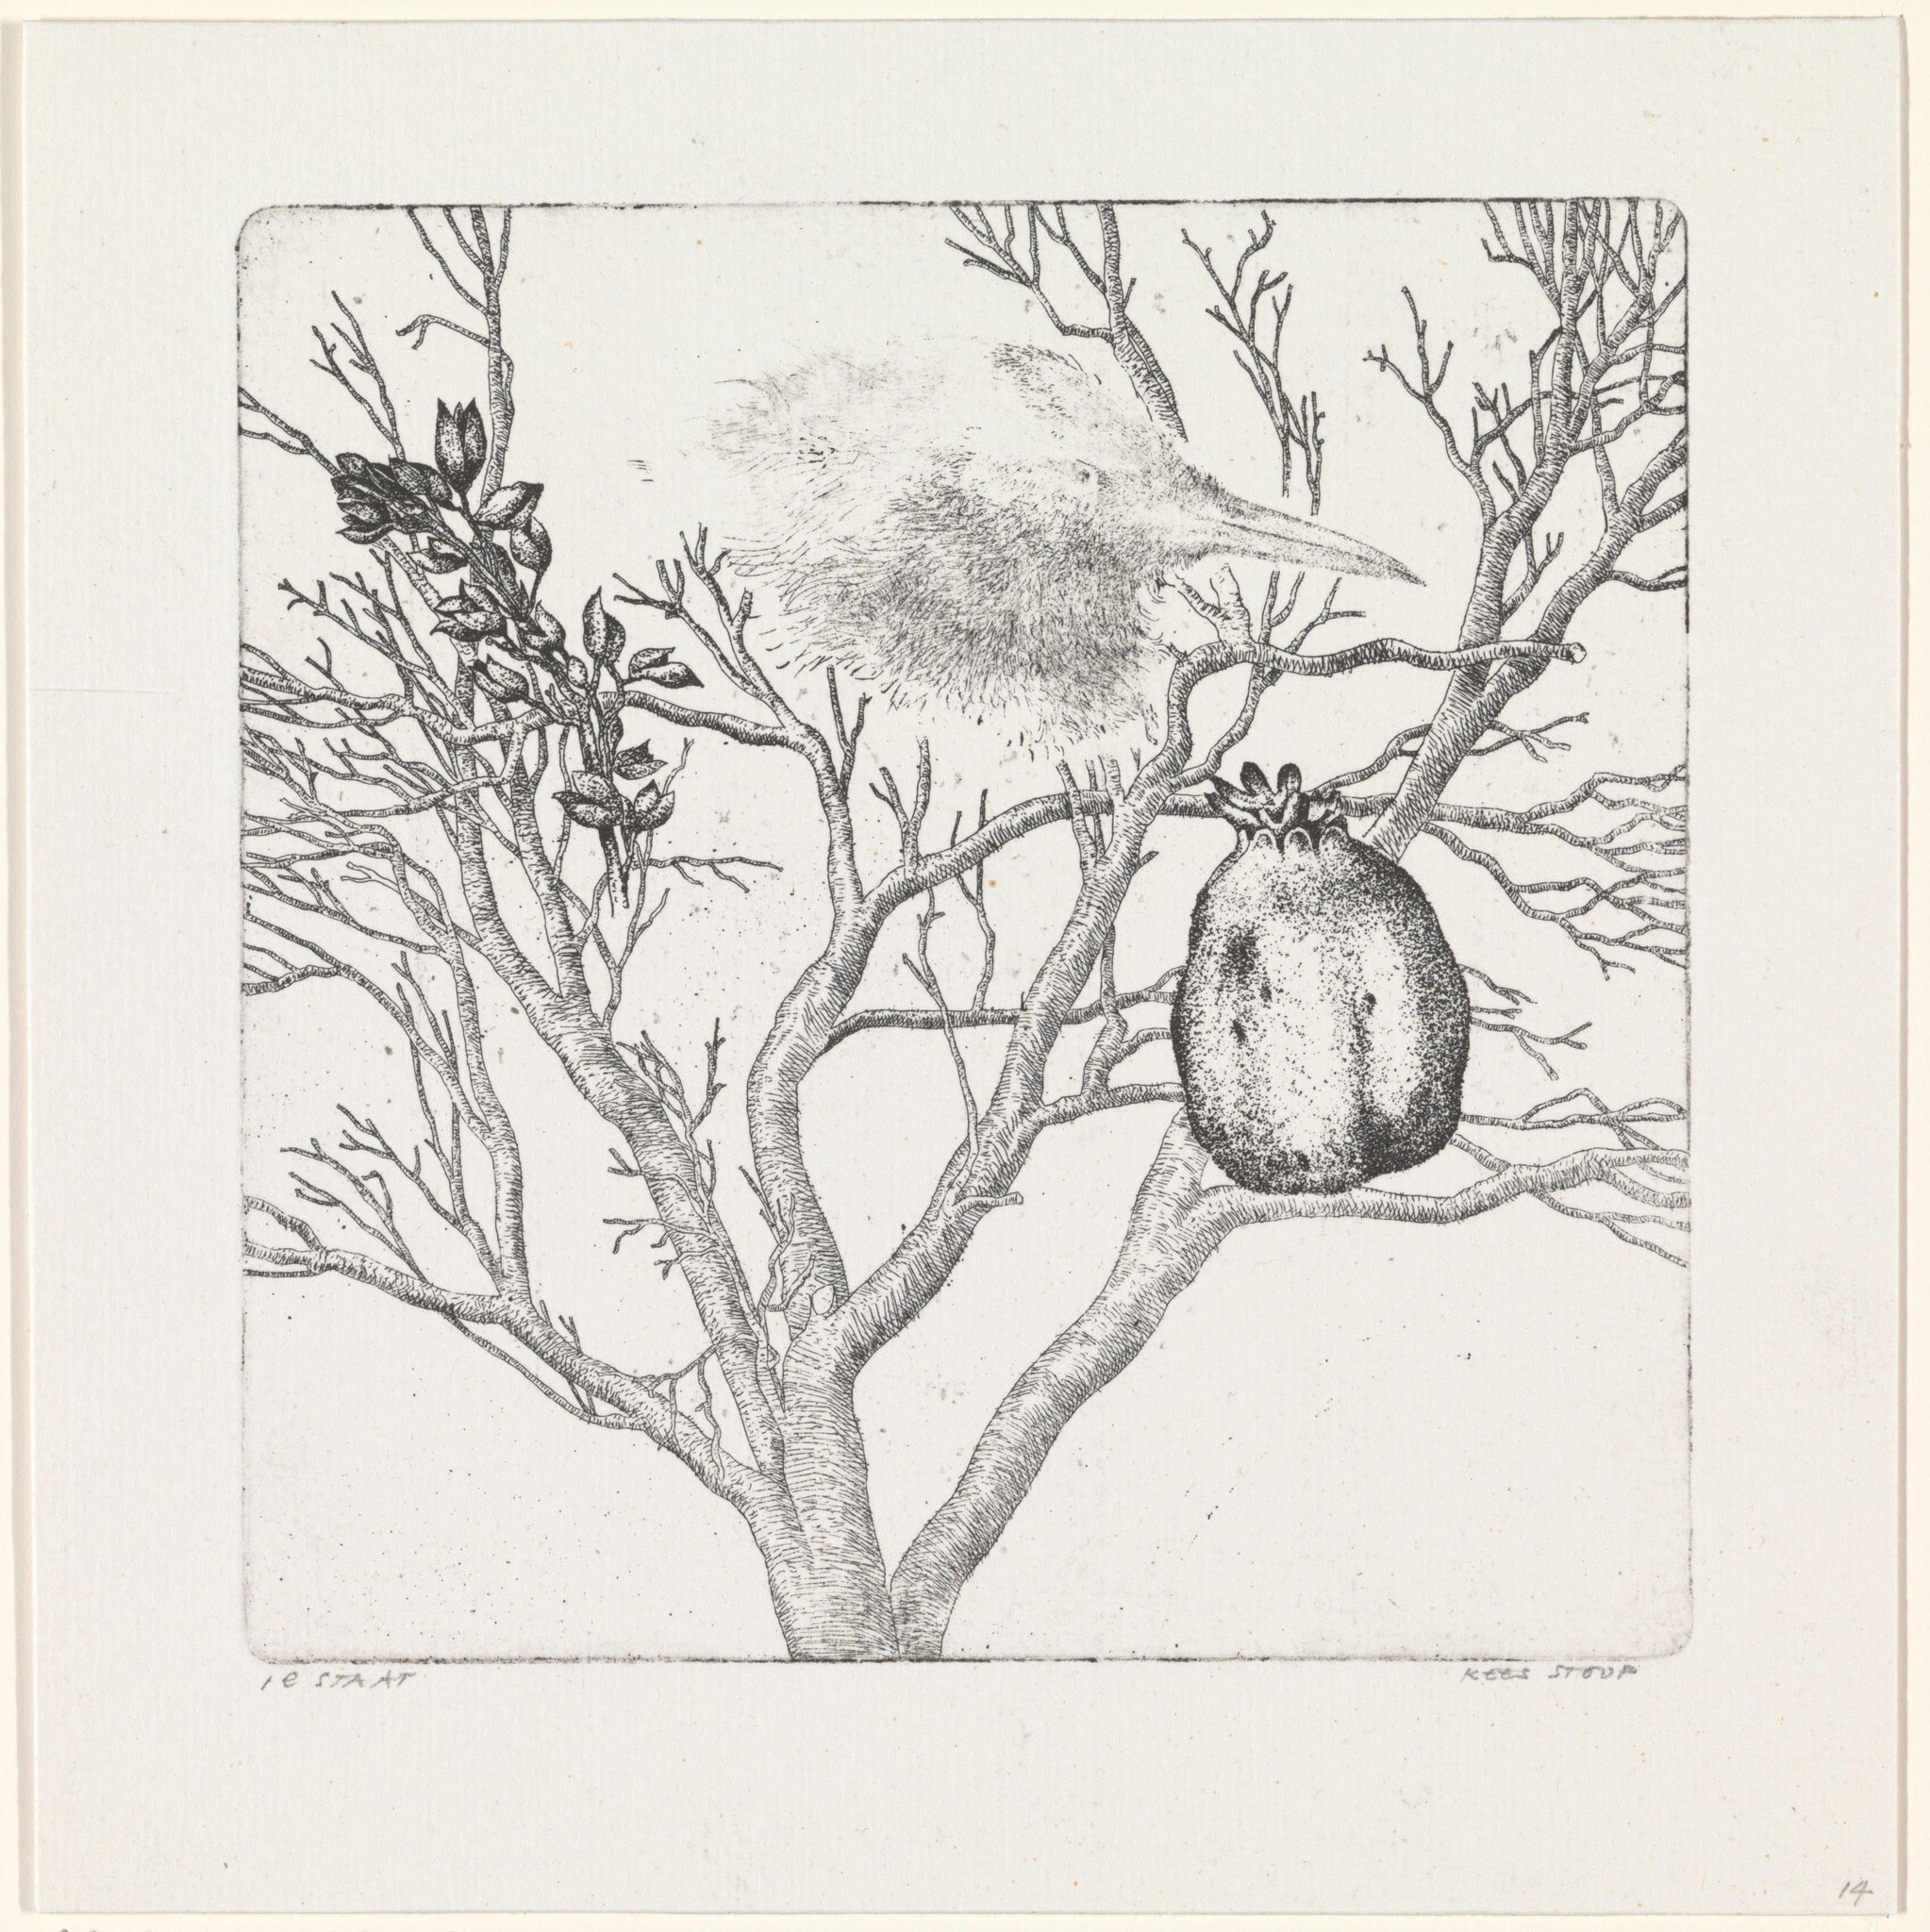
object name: print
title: Granaatappel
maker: kees stoop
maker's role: draughtsman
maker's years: 1929-2019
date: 1979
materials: paper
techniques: etching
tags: fruits: pomegranate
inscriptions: signature: ‘KEES STOOP’, date: ‘'79’, inscription: ‘1e STAAT’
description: Granaatappel in boom met vaag weergegeven vogel erboven.